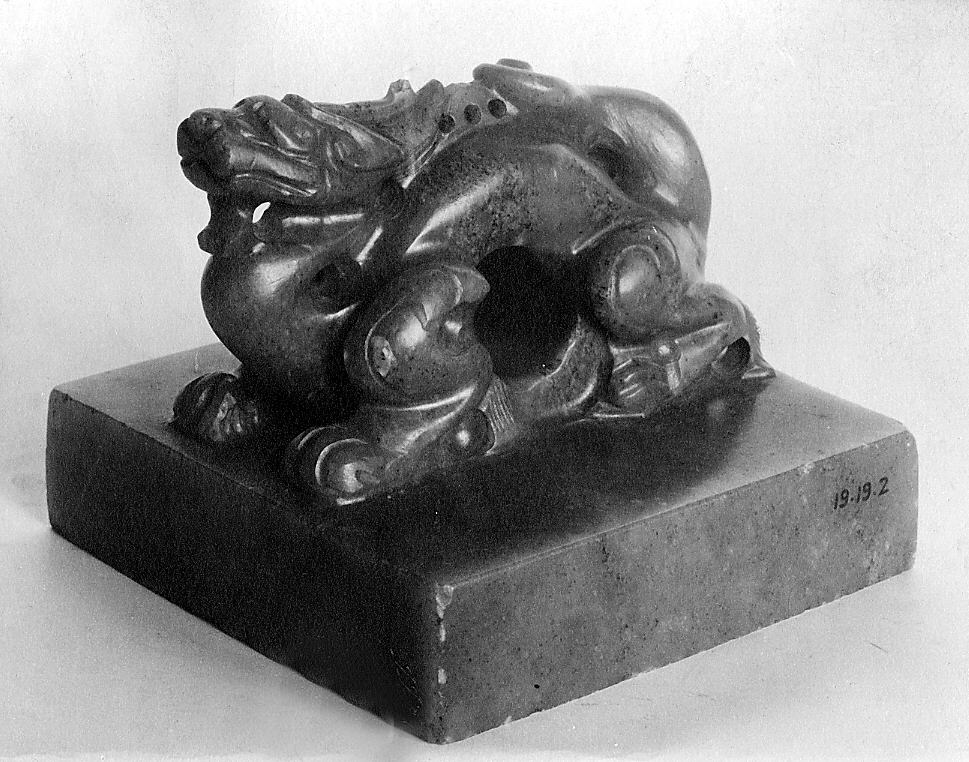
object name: seal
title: Seal from the Imperial Palace, Peking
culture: chinese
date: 960-1279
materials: jade